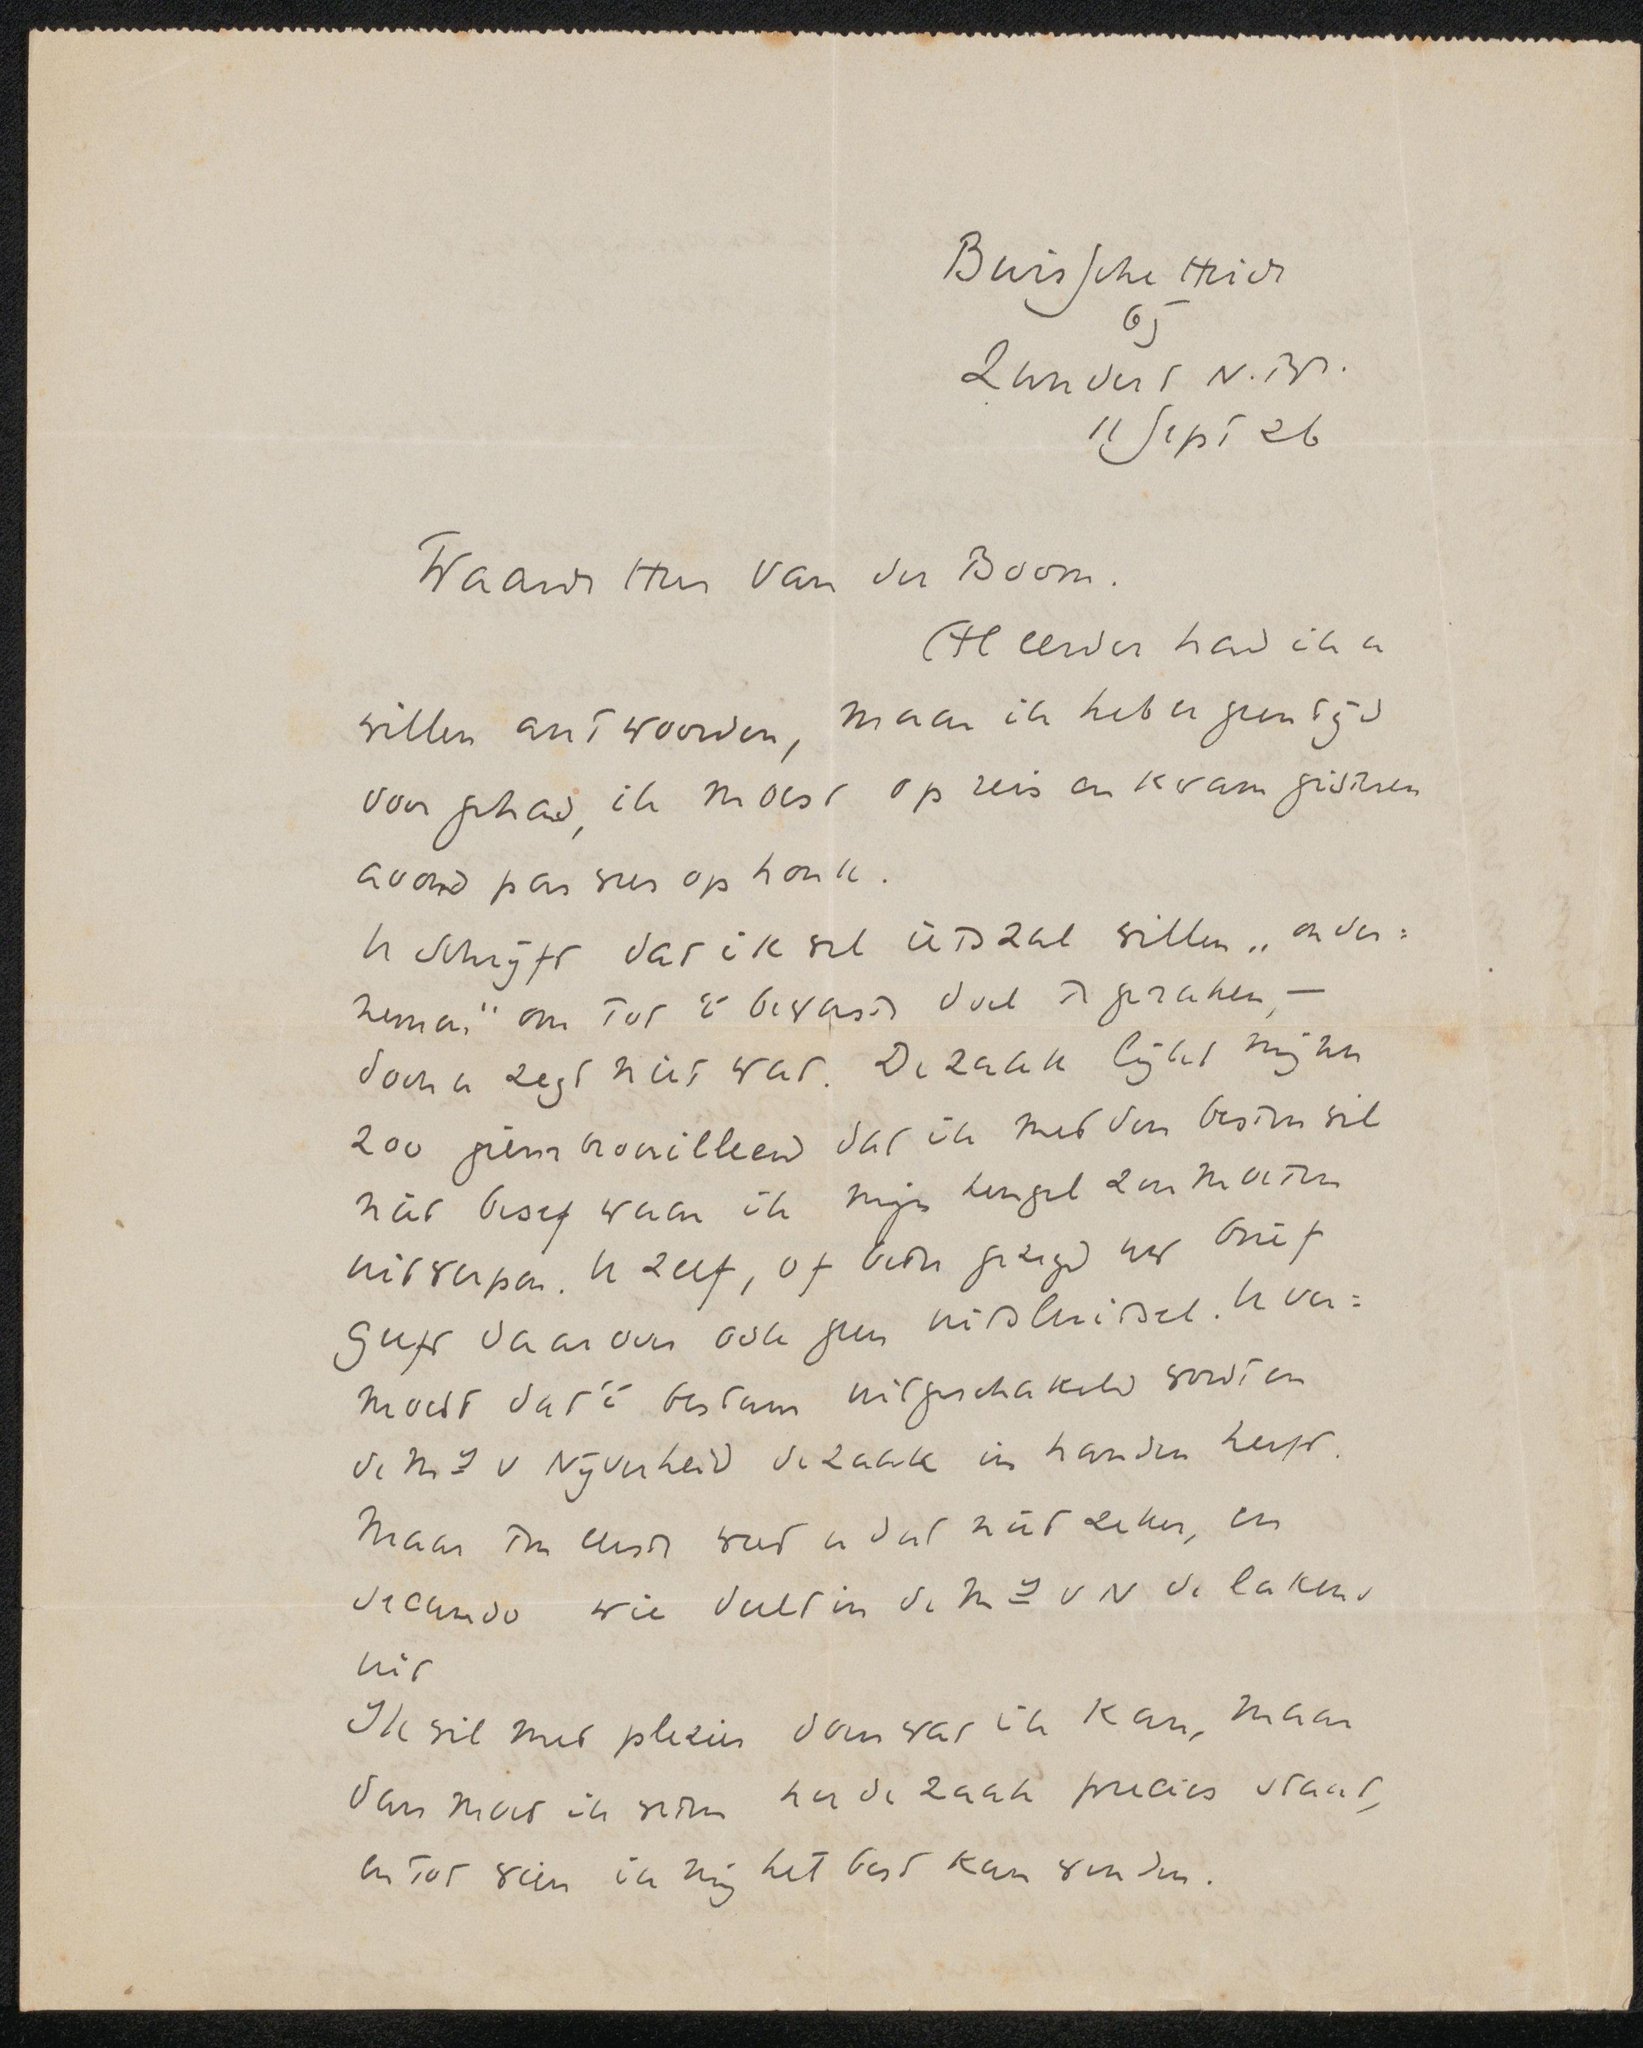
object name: letter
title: Brief aan A. van der Boom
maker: richard nicolaüs roland holst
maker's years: 1868-1938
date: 1926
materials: ink, paper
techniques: pen, writing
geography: buissche heide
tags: a. van der boom, rotterdam, george hendrik breitner, den bosch, amsterdam, painter, print maker, draughtsman, antoon derkinderen, willem witsen, sculptor, hildo krop, haarlem, jac van looij, jan sluijters, matthieu wiegman, the hague, jan toorop, applied arts, arts and crafts; industrial design, education, tuition of the artist (in general)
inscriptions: watermark, collector's mark: Lugt L.2228a